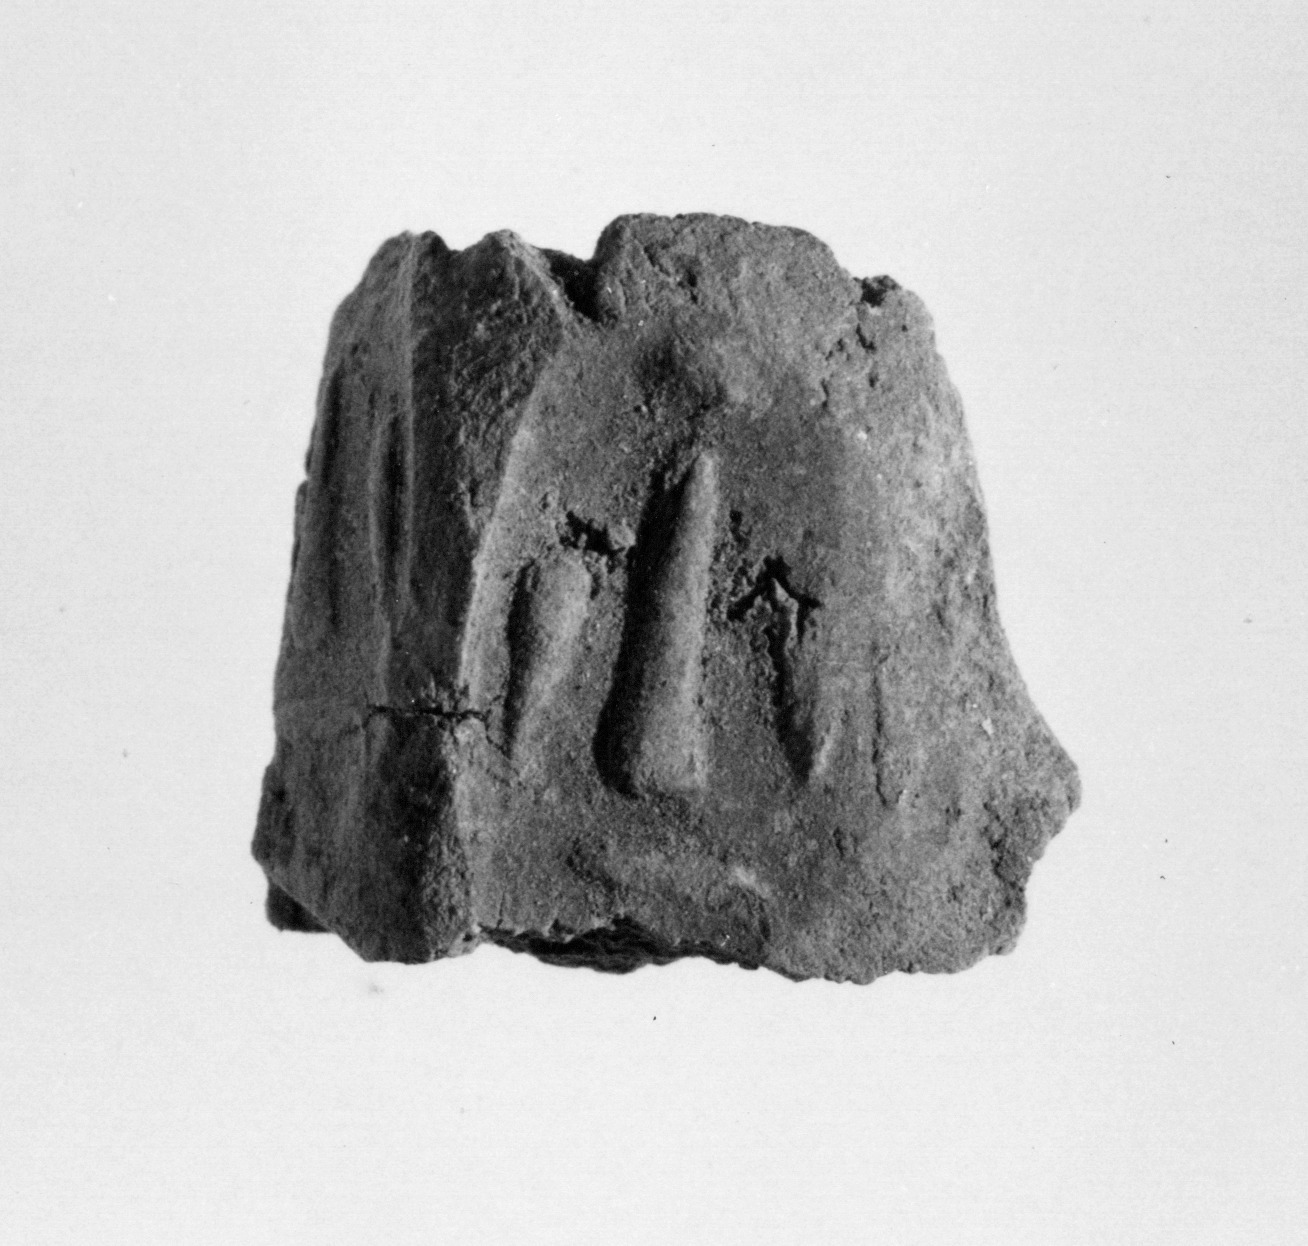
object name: sealing, djed, cobra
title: Document Sealing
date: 1390-1352 BCE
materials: mud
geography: egypt